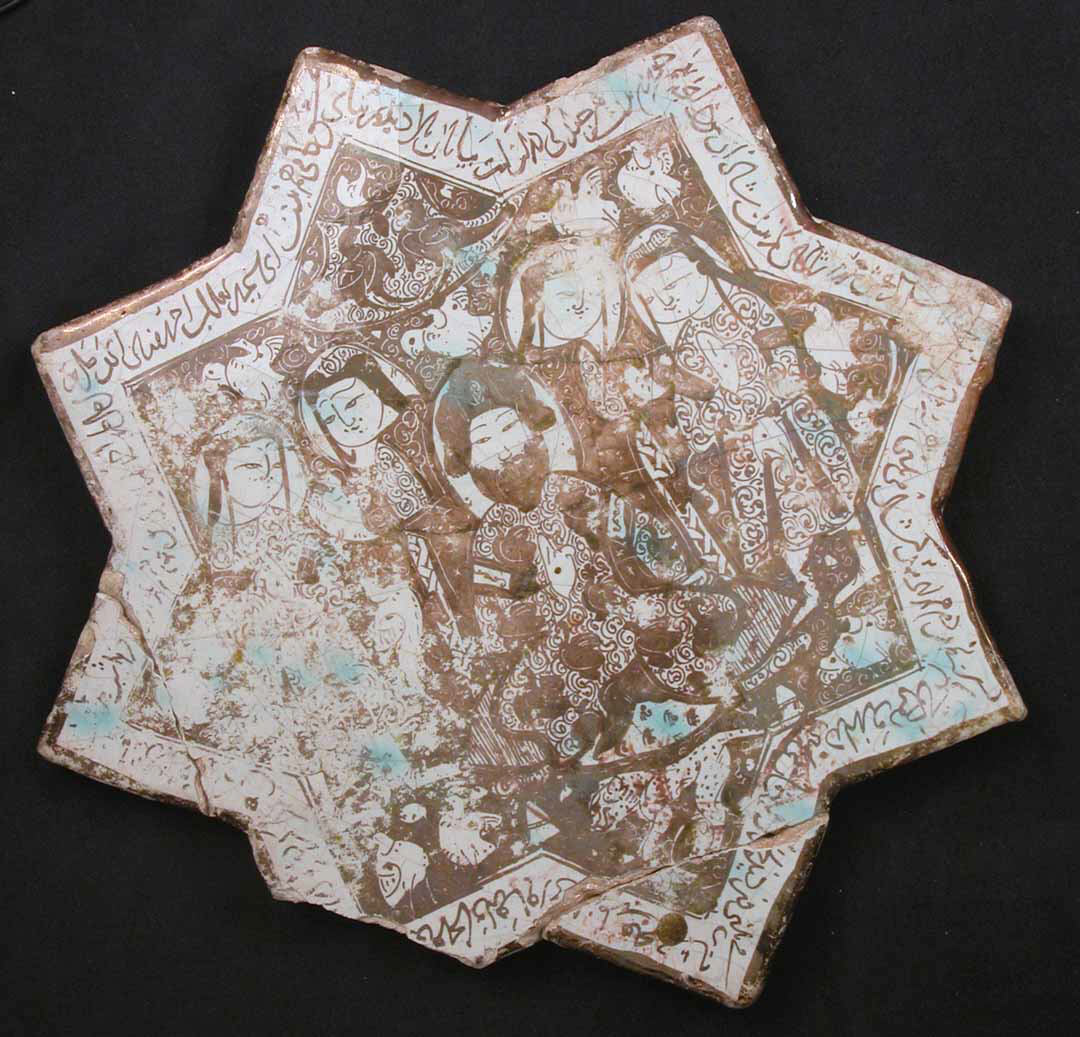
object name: tile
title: Luster Star-Shaped Tile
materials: glaze, stonepaste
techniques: luster painting, painting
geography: iran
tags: birds,kings,women